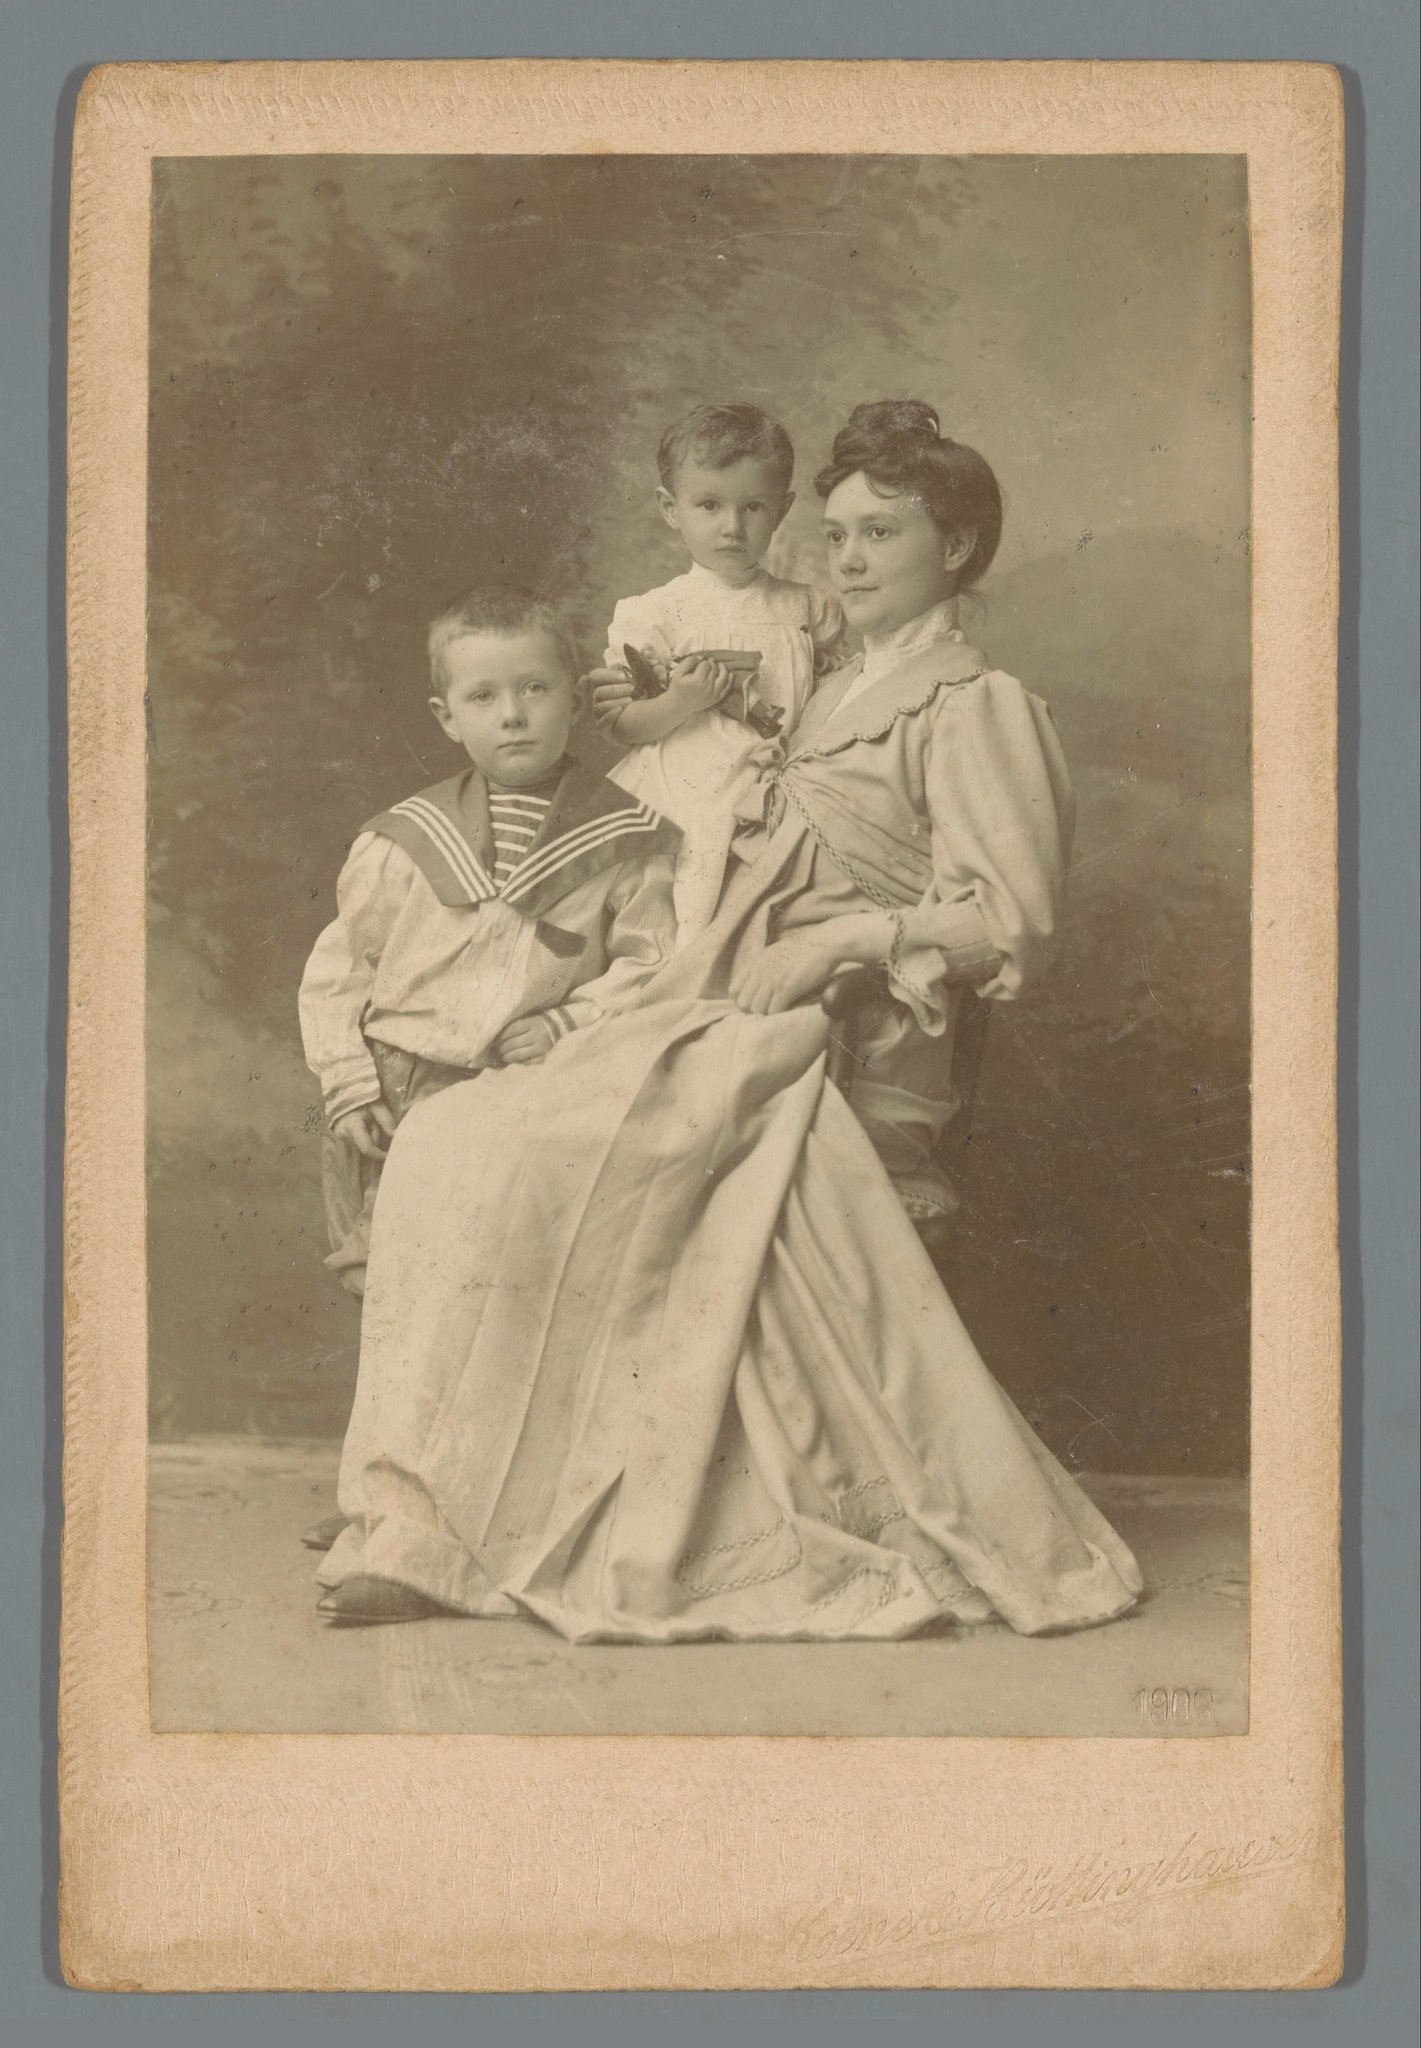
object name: cabinet photograph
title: Portret van een moeder met twee kinderen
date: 1887-1919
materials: cardboard, photographic support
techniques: matte daylight collodion silver print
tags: adult woman, mother and child(ren), woman and child(ren) (family group)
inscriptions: number: ‘1906.’